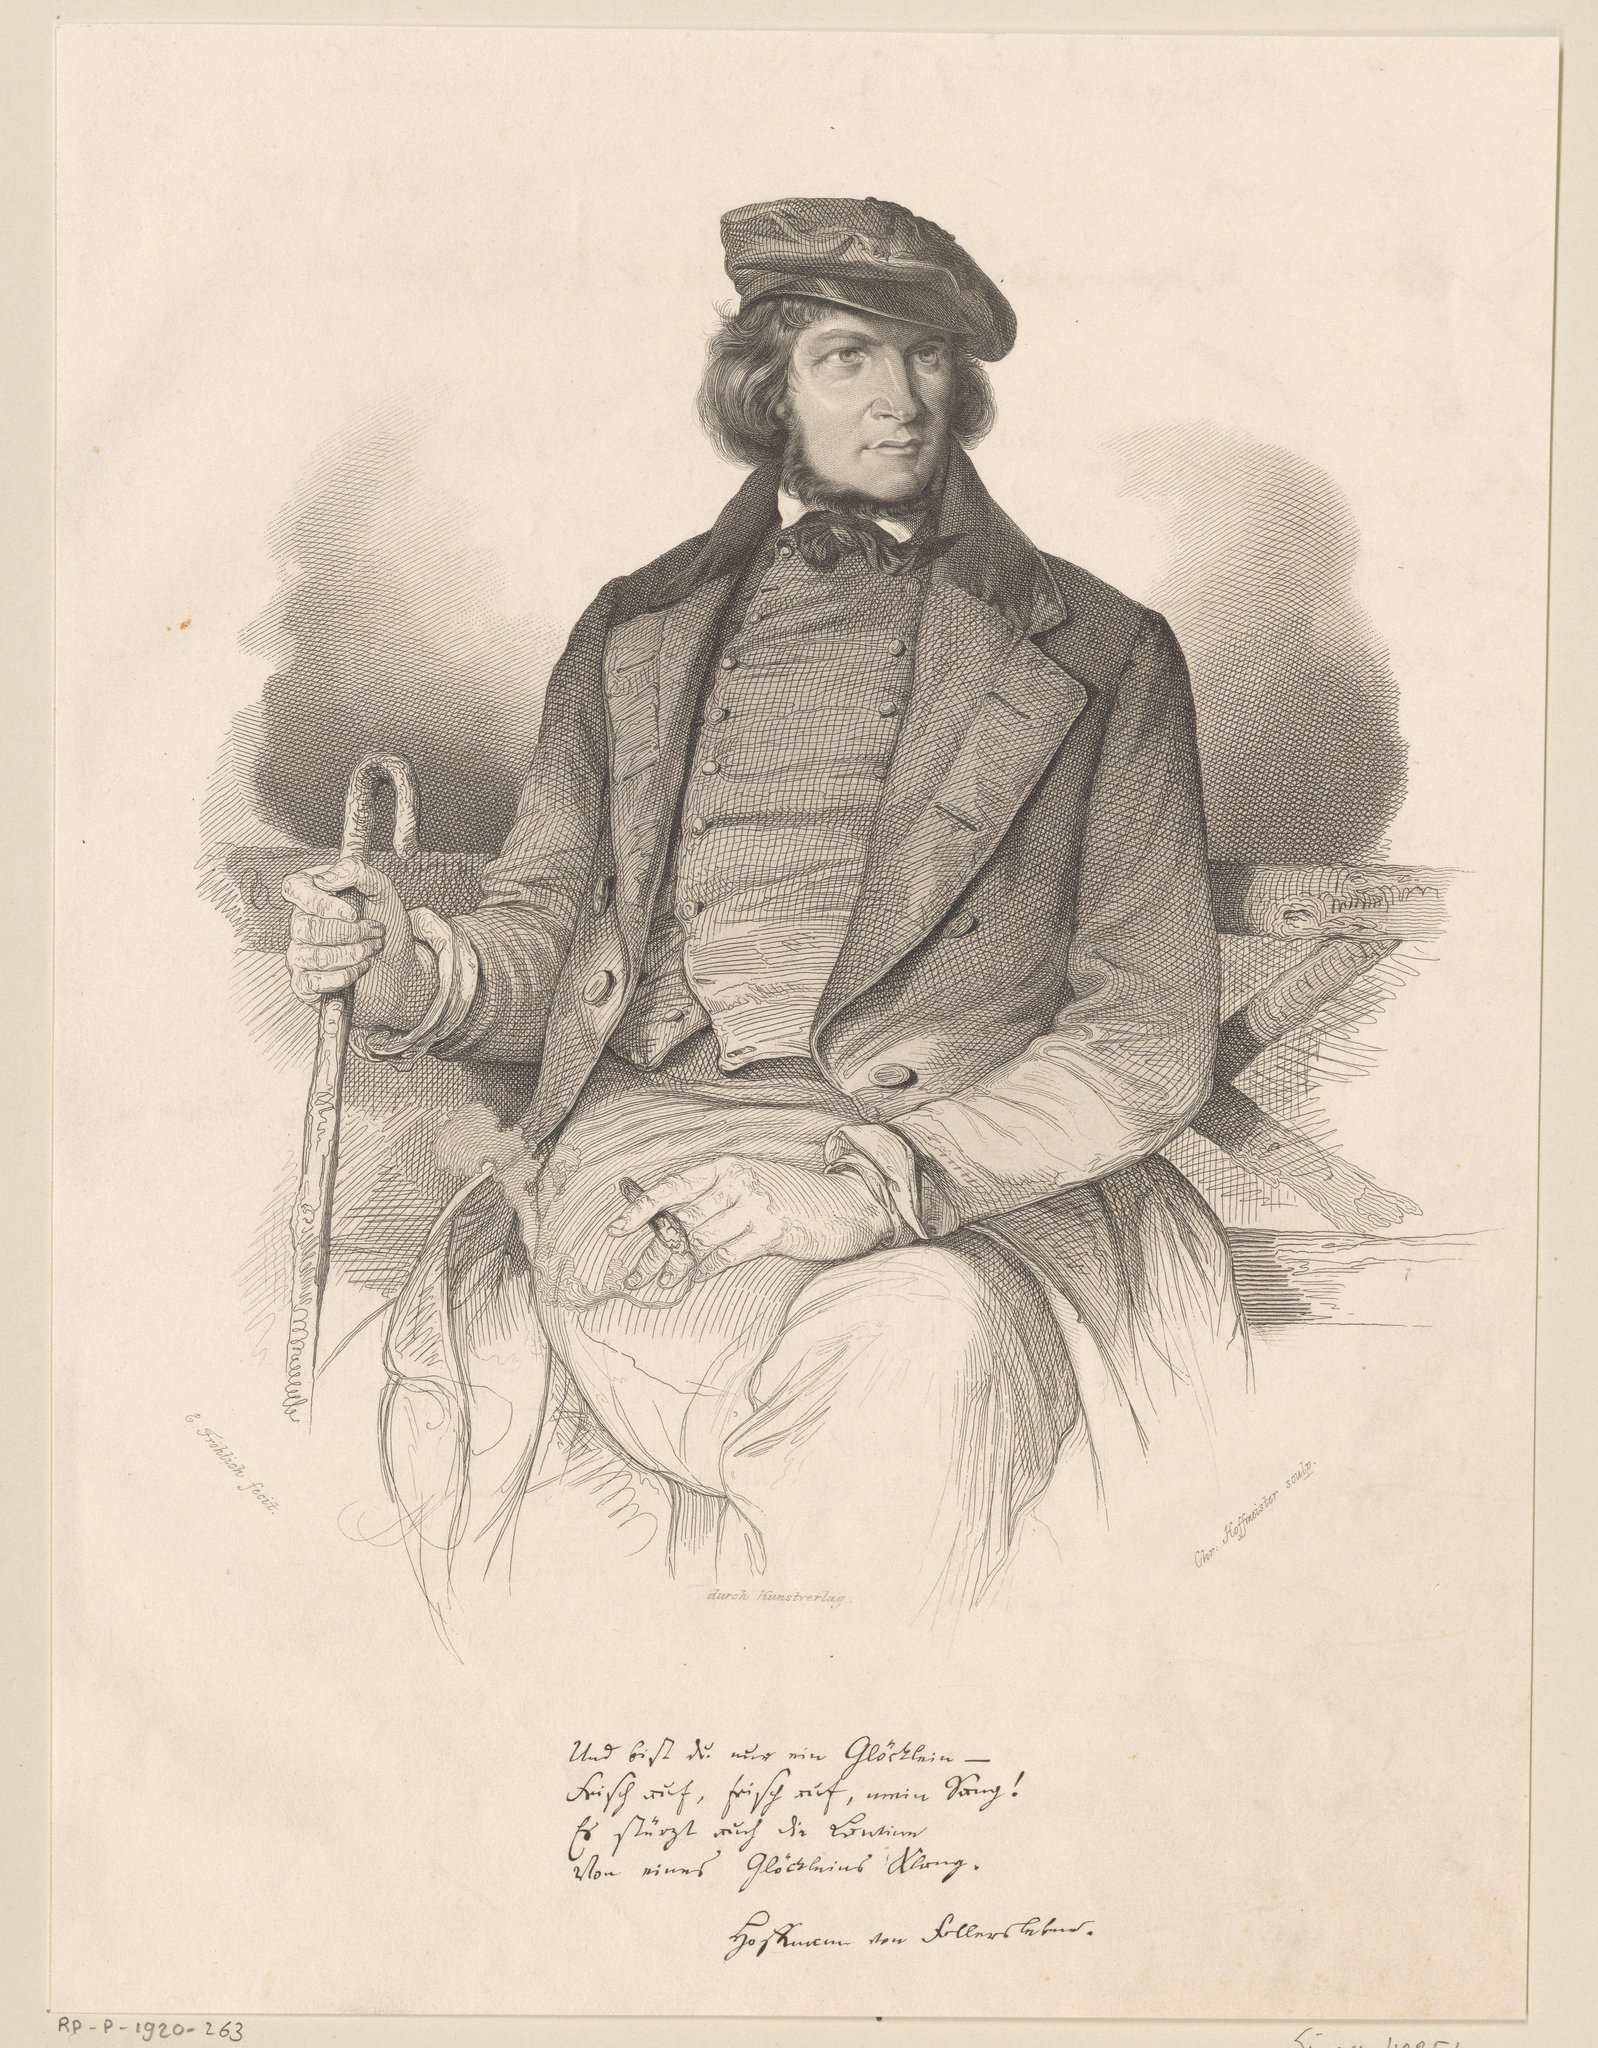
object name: print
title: Portret van August Heinrich Hoffmann von Fallersleben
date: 1828-1871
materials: paper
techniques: etching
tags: historical persons, writer, poet, author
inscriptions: collector's mark: Lugt 2228